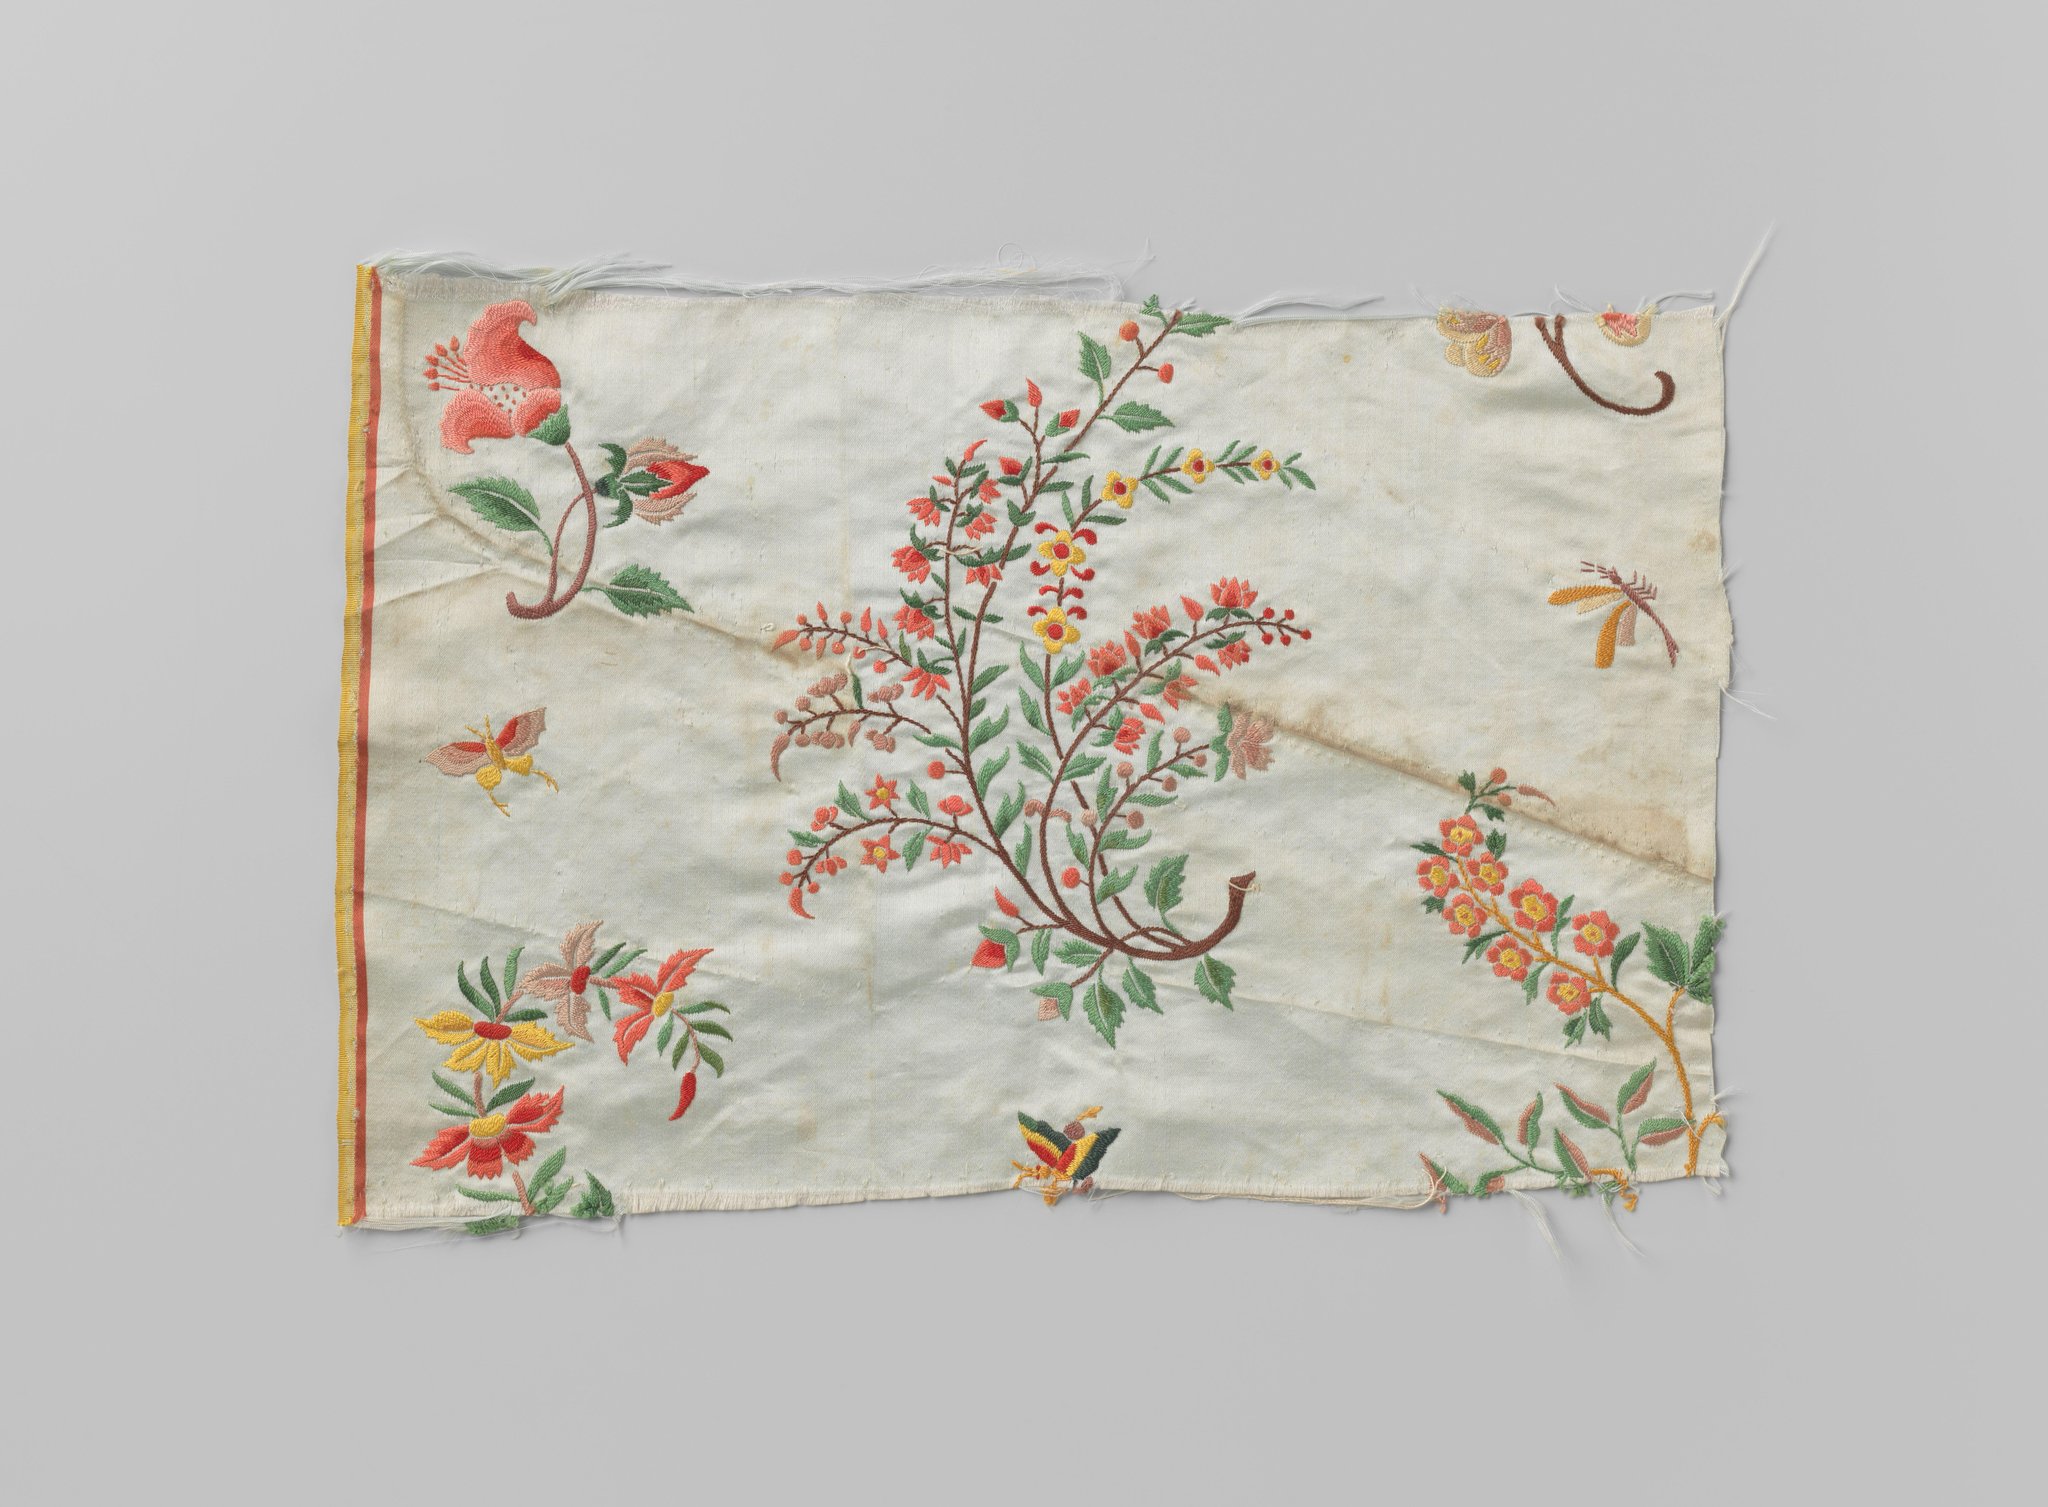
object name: womenswear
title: Zijden geborduurd fragment van een japon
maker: Anonymous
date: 1750-1800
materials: silk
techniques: embroidered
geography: indonesia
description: Een heidetak staat midden tussen twee verspreide vlinders, een libelle en vier andere middelgrote bloemtakken.